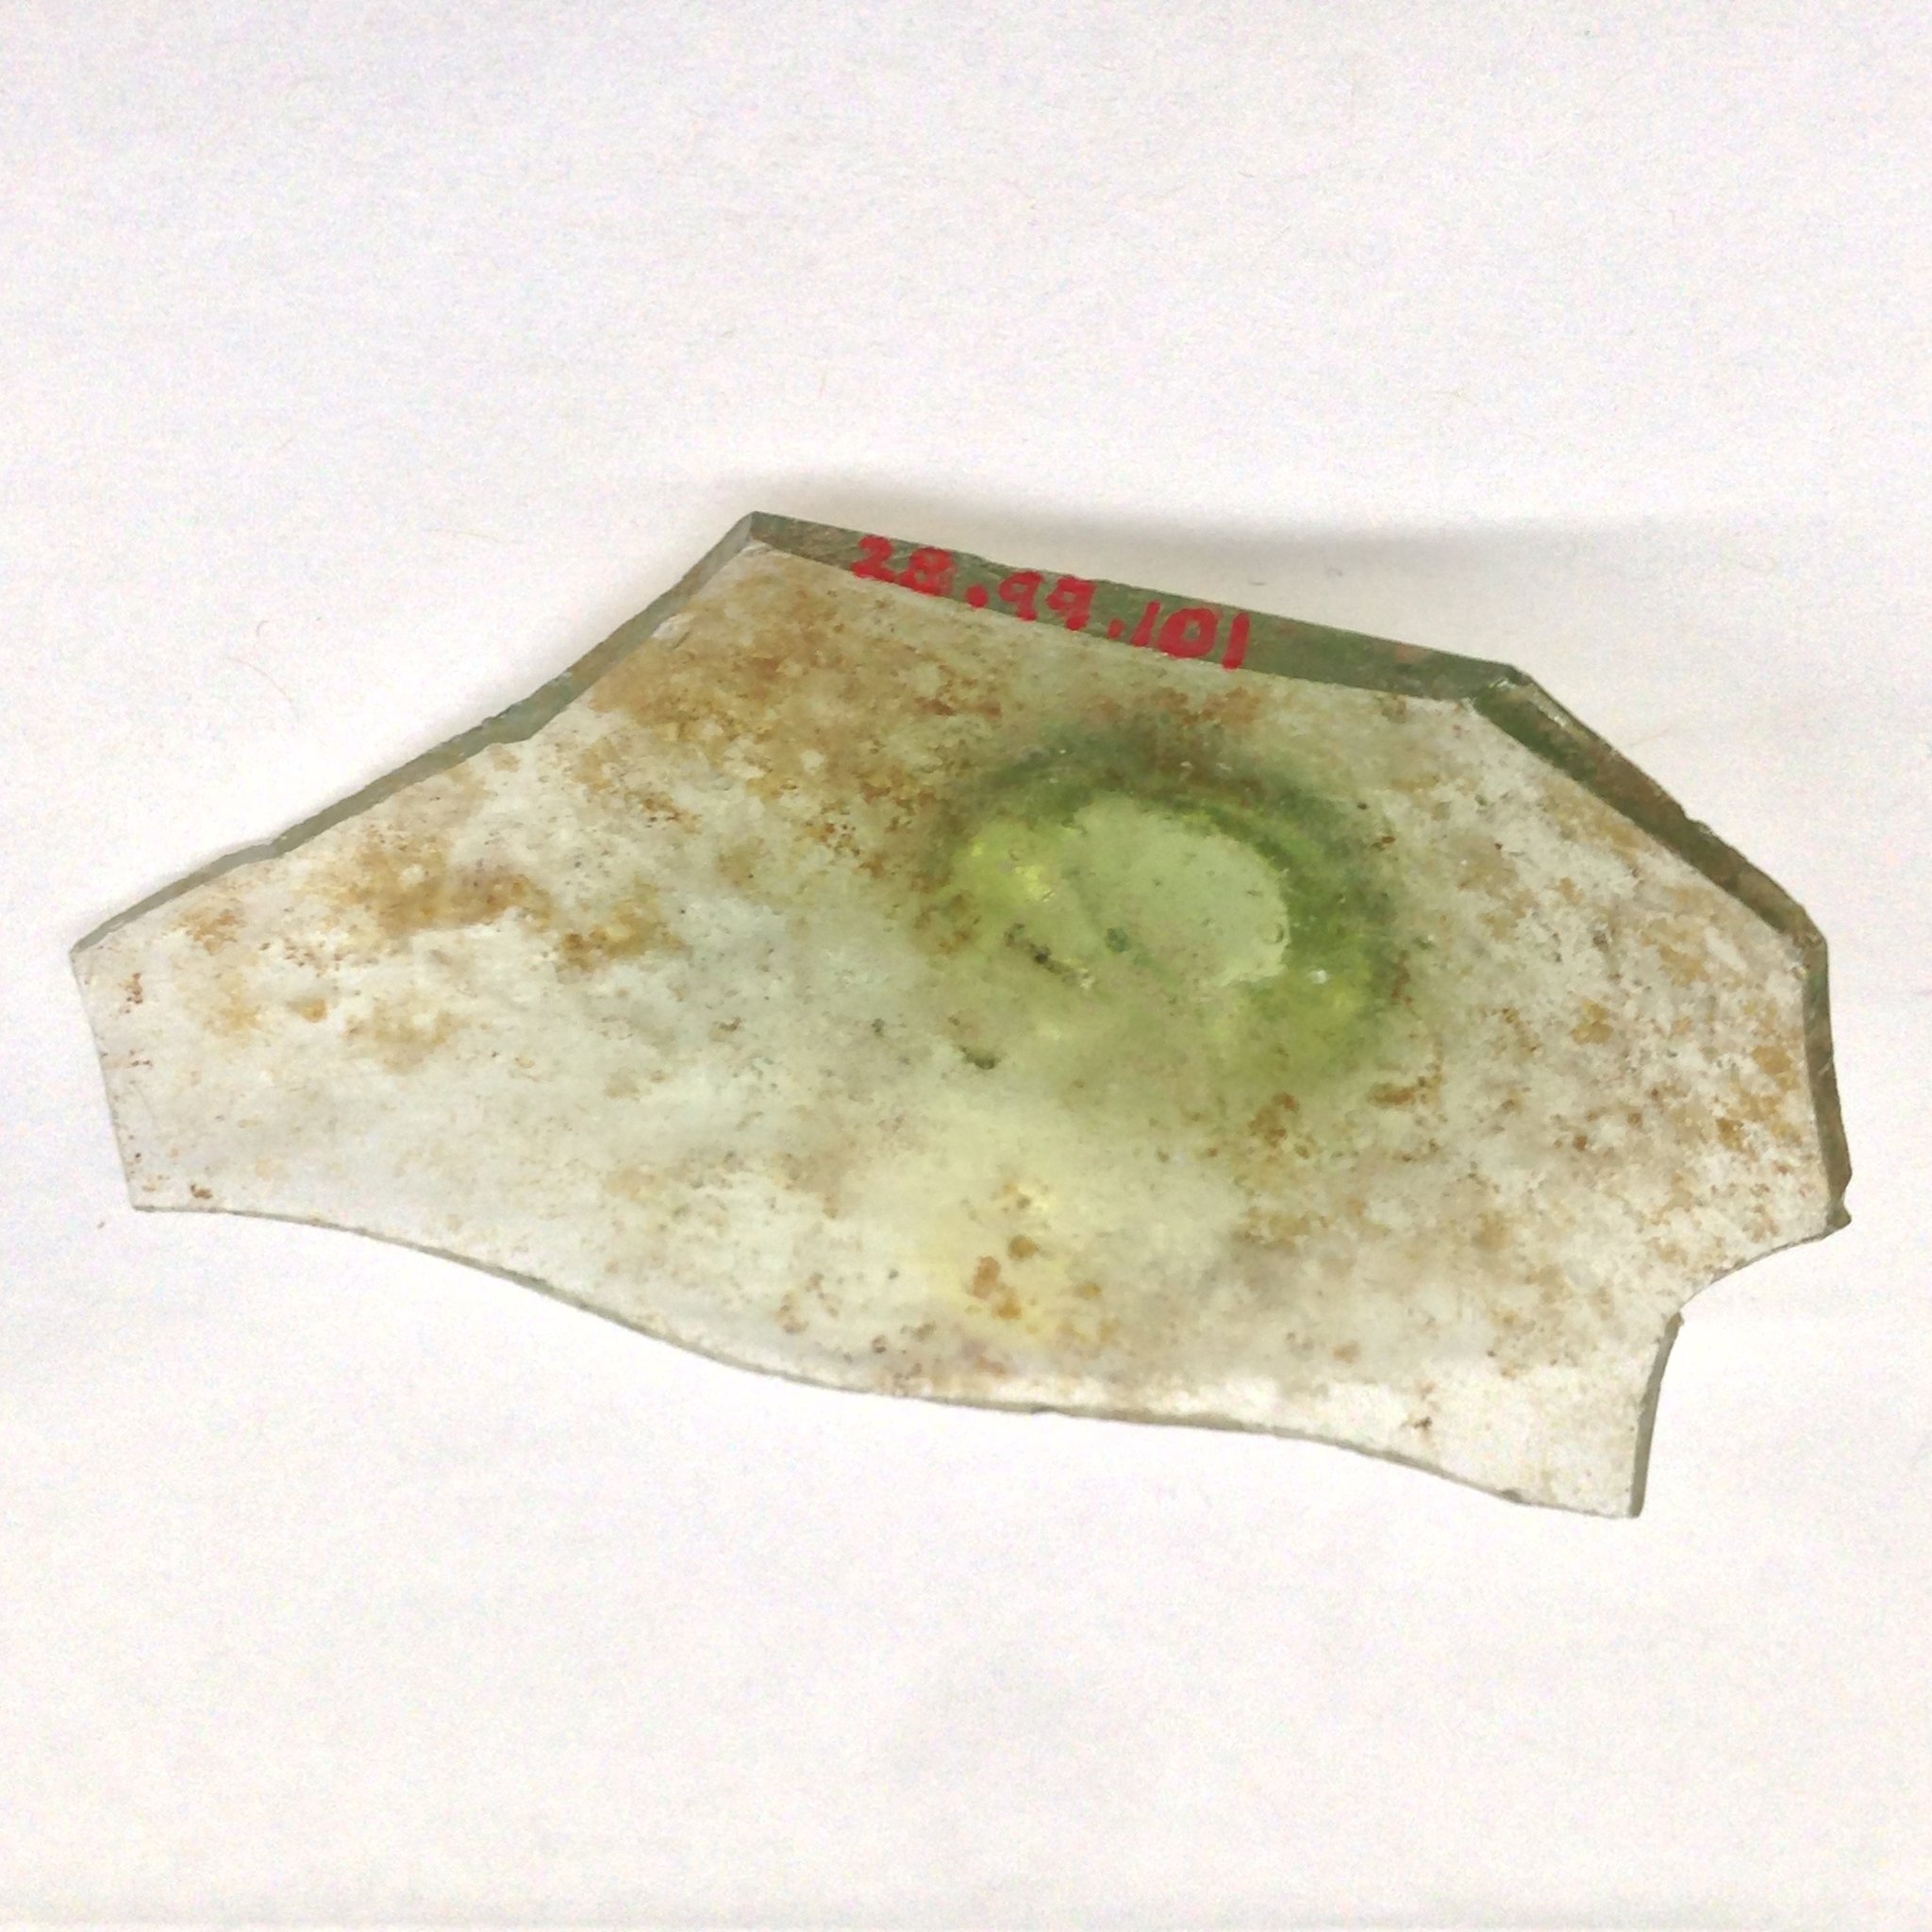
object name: fragment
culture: european or middle eastern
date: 1150-1250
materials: ceramic, glass